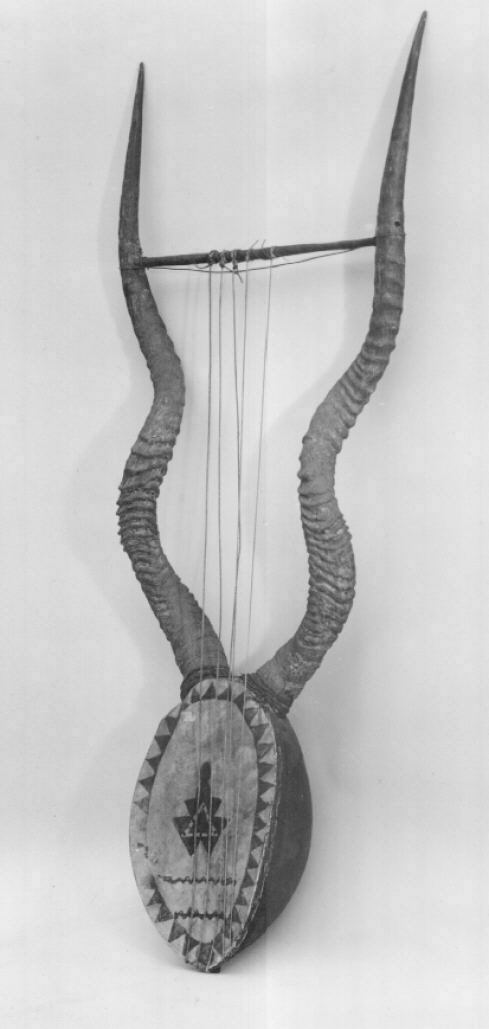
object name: lyre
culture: east african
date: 1801-1900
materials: skin, wood